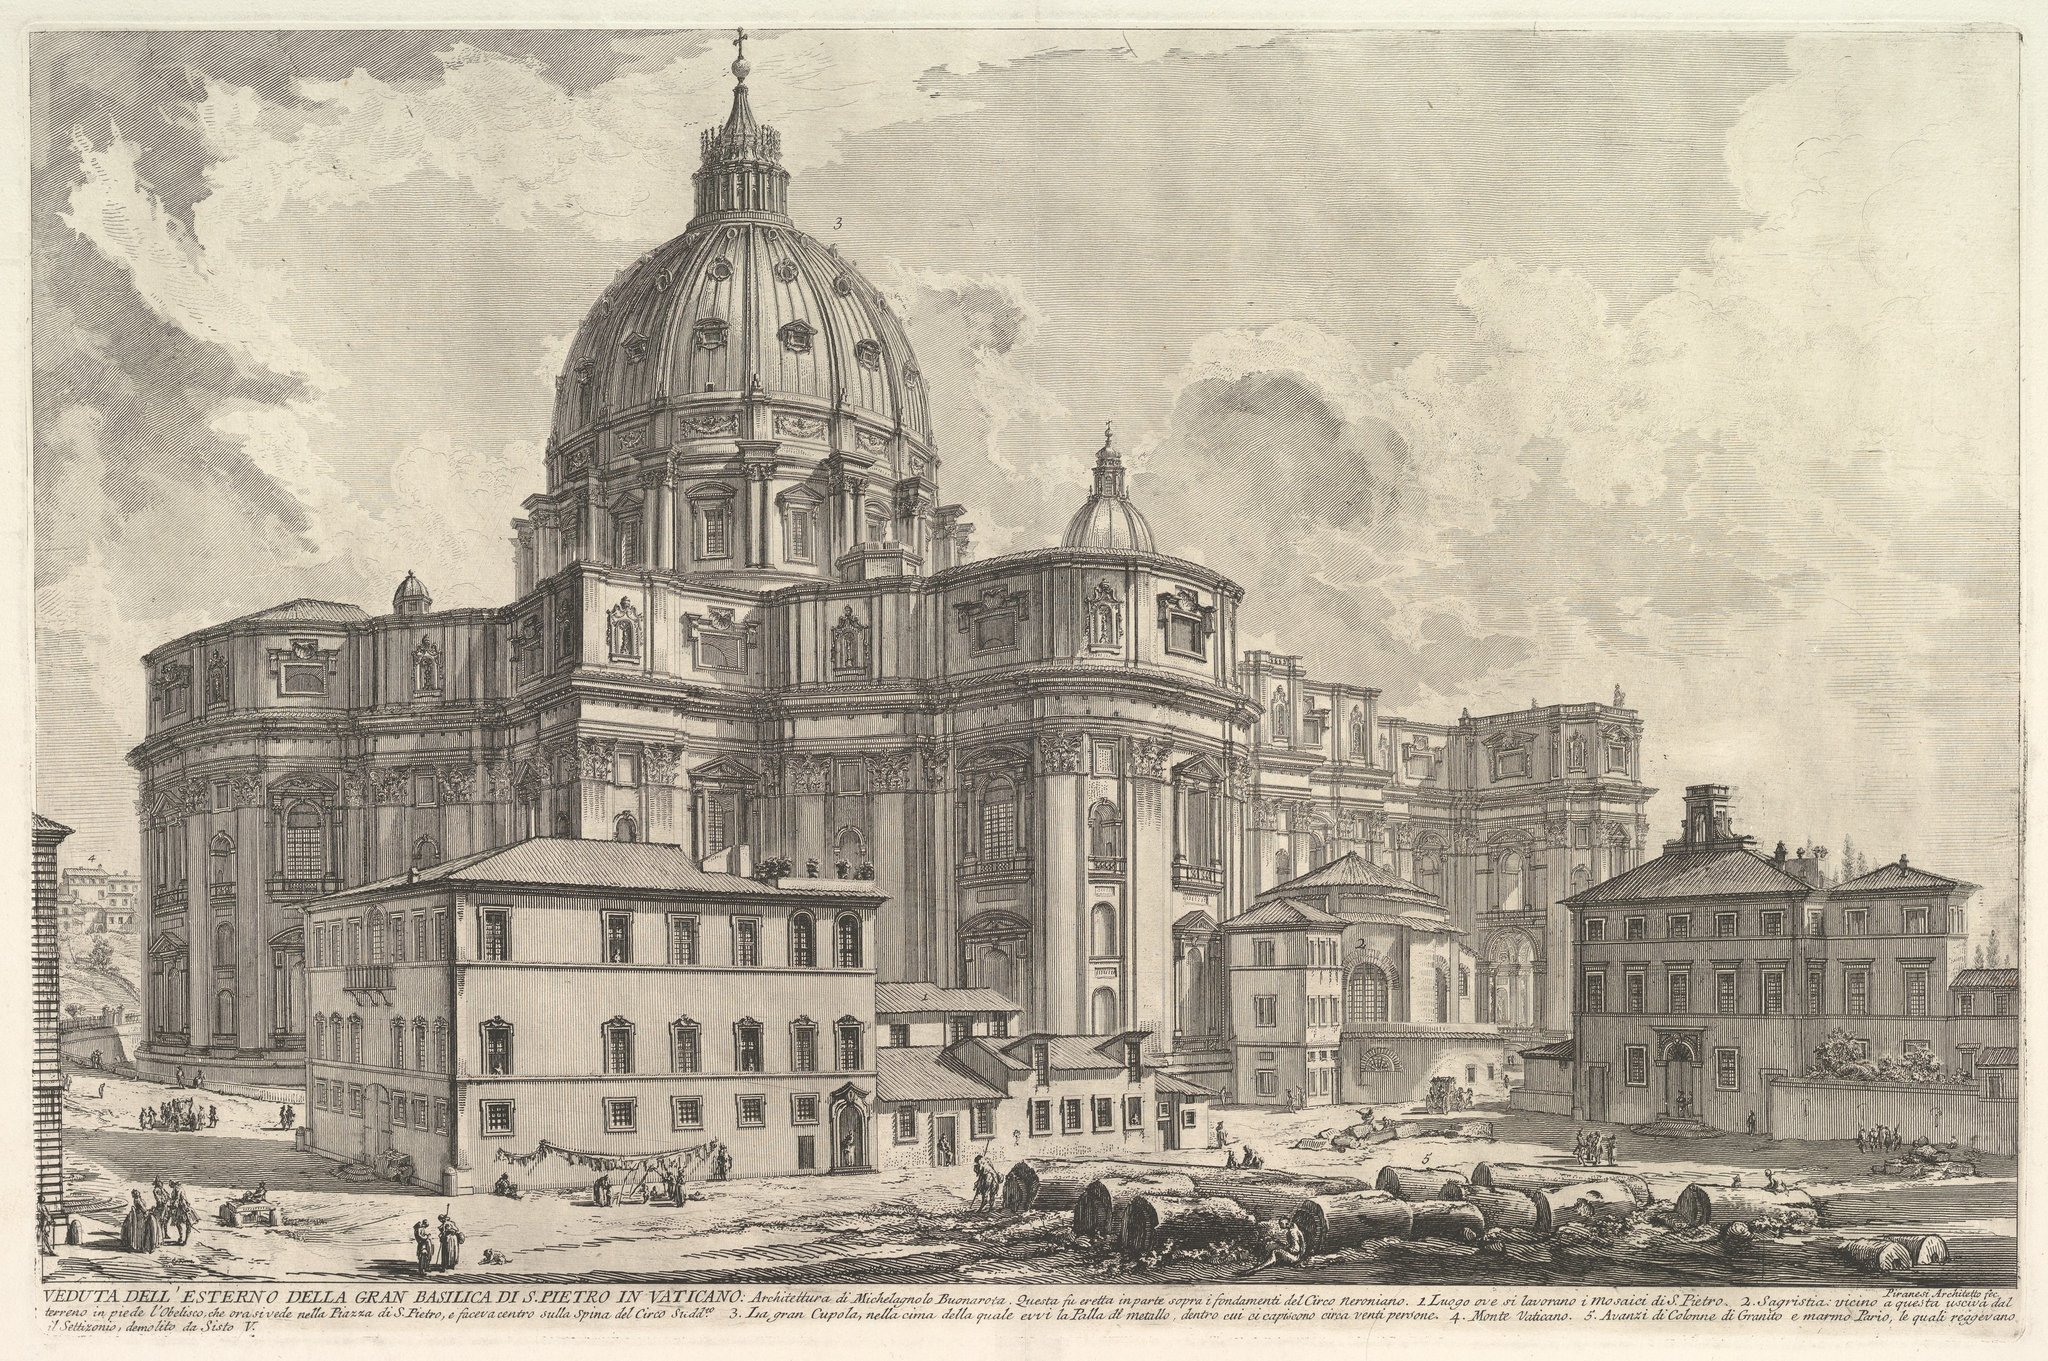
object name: print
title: View of the exterior of St. Peter's Basilica in the Vatican, from Vedute di Roma (Roman Views)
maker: giovanni battista piranesi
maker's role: artist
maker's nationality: italian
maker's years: 1720-1778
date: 1748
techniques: etching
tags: churches,rome